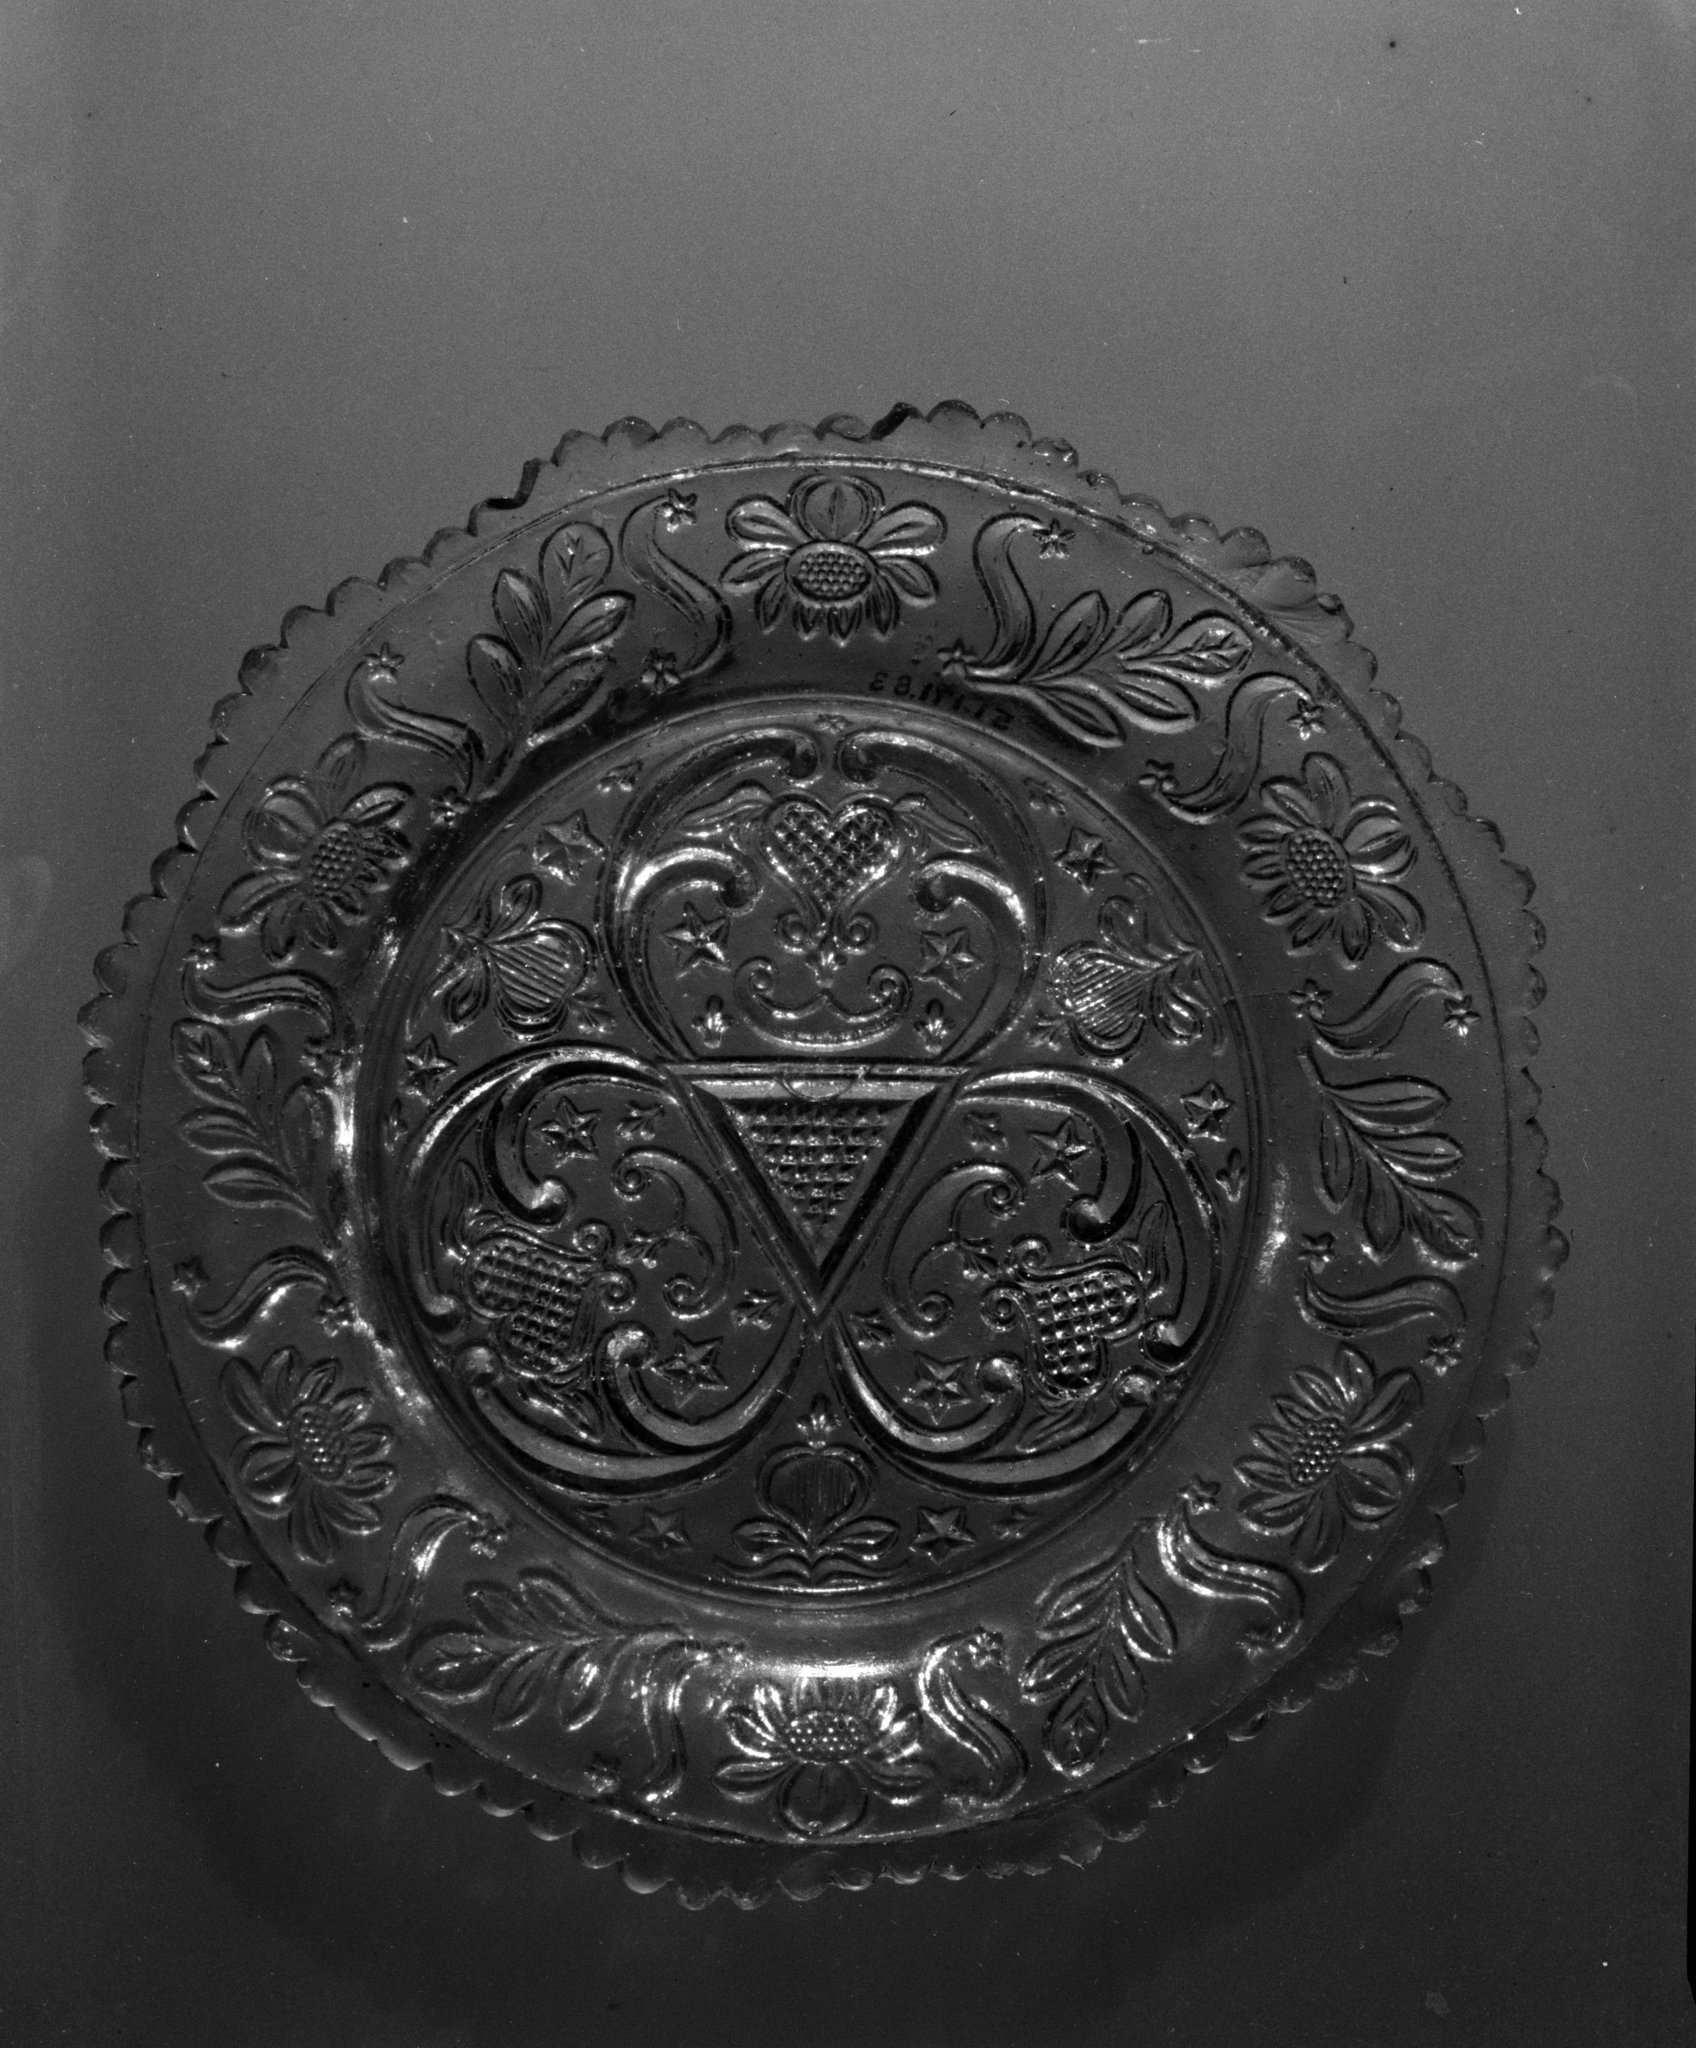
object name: plate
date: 1840-1850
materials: glass